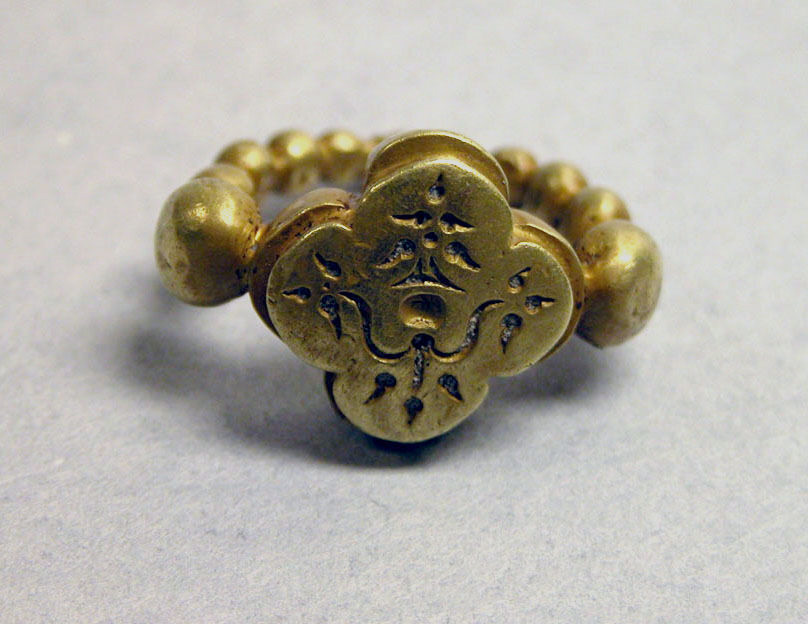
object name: ring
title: Ring with Quatrefoil-shaped Bezel with "Sri" Inscription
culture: indonesian, javanese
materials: gold